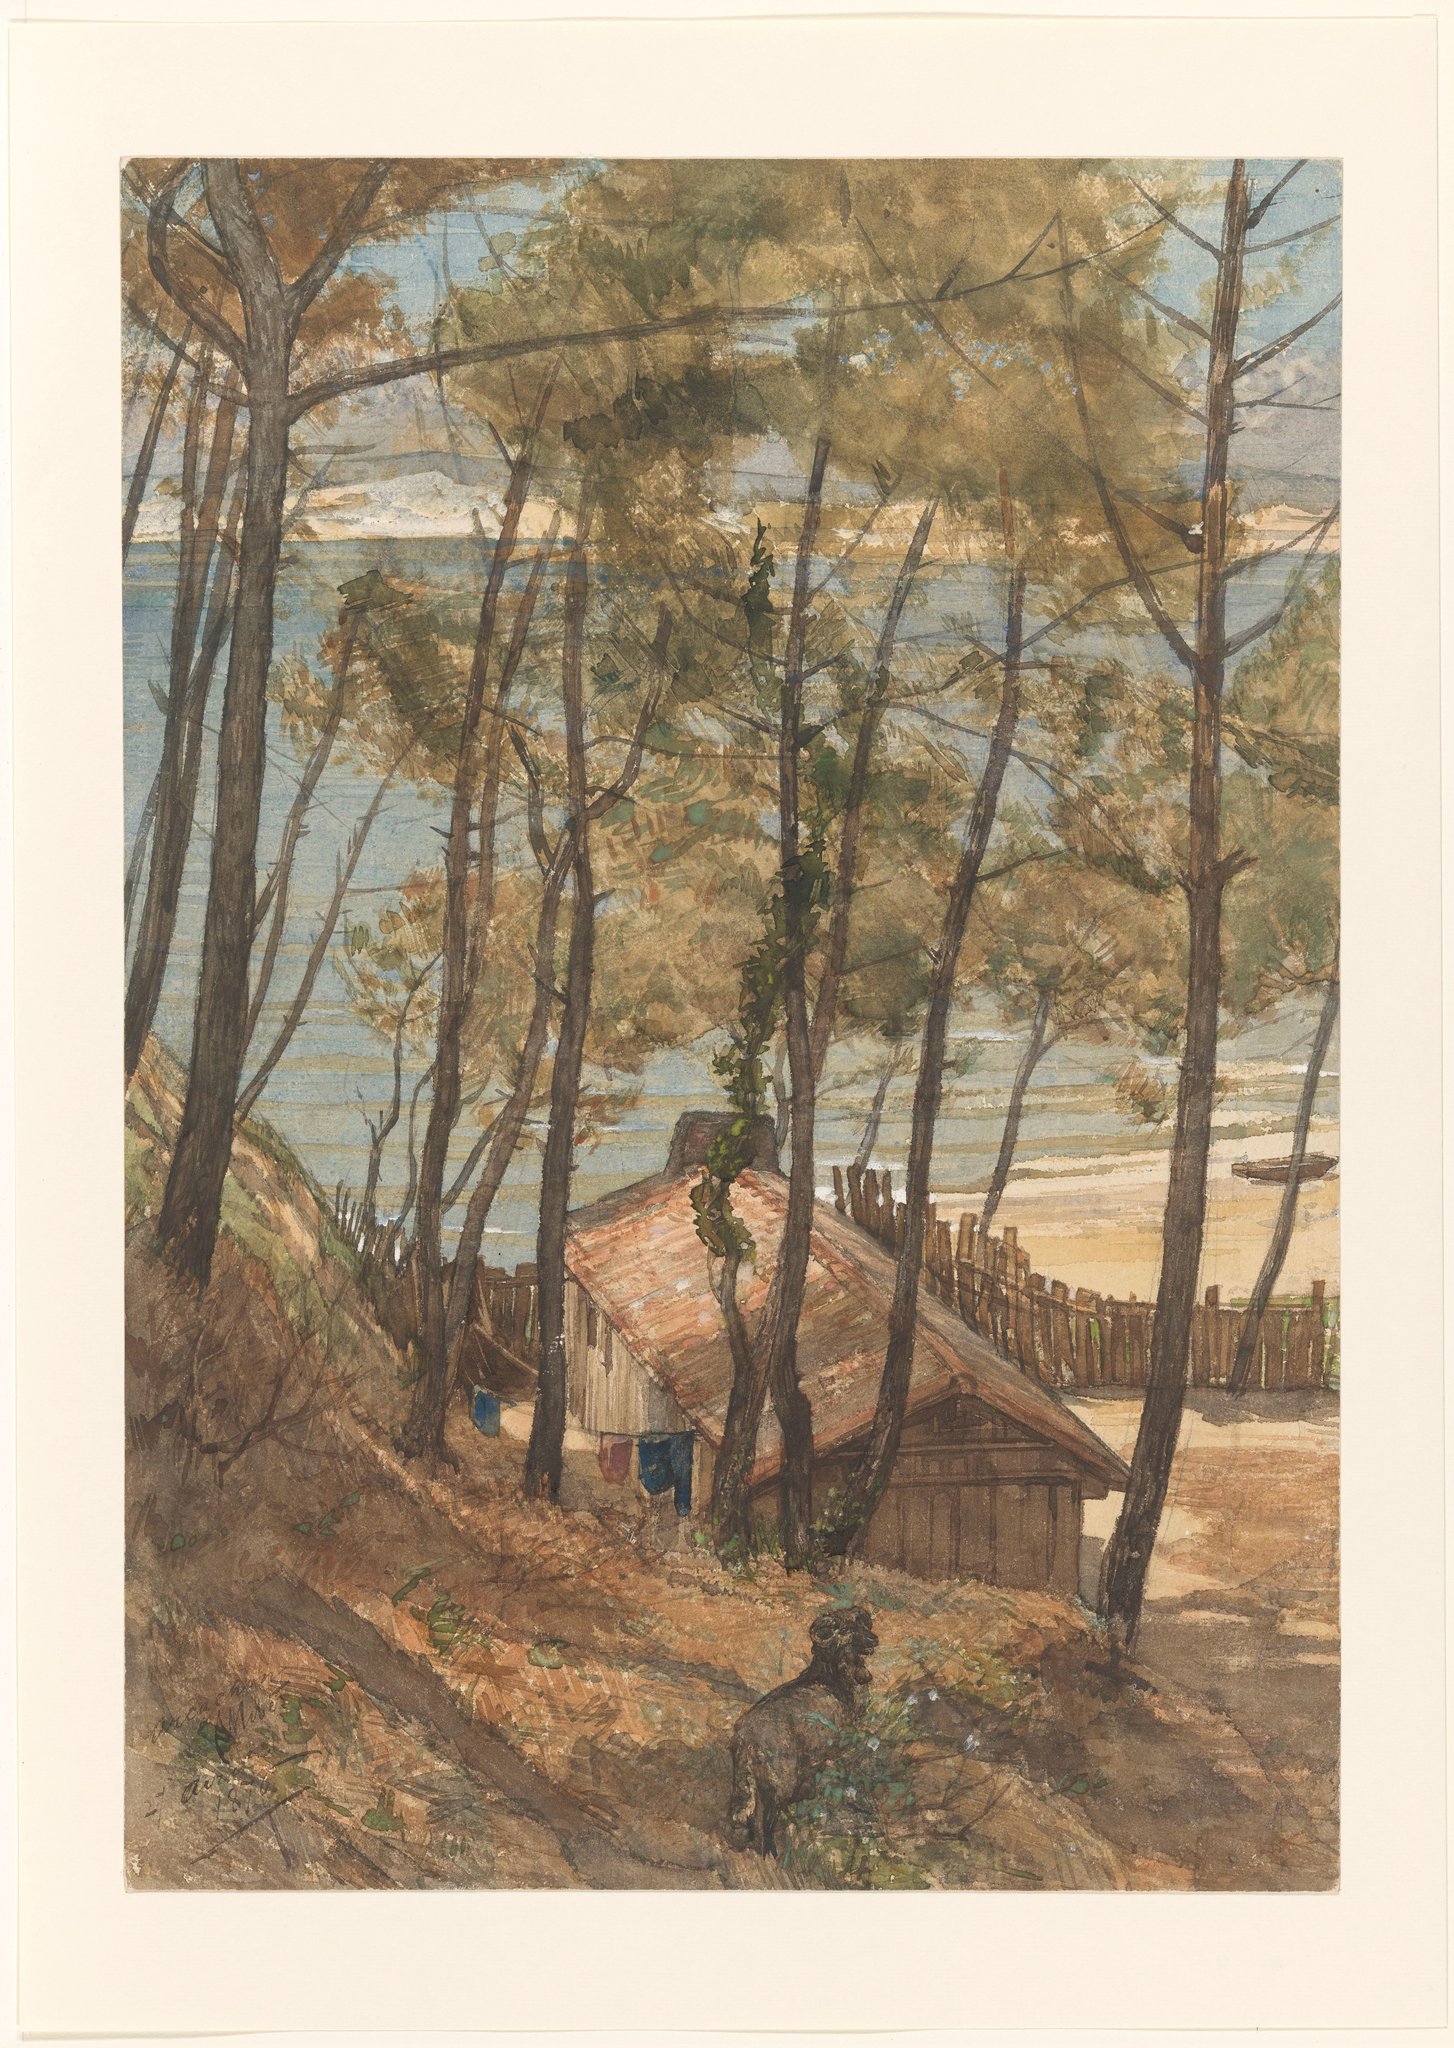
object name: drawing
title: Gezicht vanaf een heuvel op een huisje aan de golf van Arcachon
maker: august allebé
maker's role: draughtsman, print maker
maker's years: 1838-1927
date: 1876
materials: paper, pencil, watercolor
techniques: brush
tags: coast, france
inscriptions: inscription: ‘Arcachon’, signature and date: ‘Allebé, 27 août 1876’